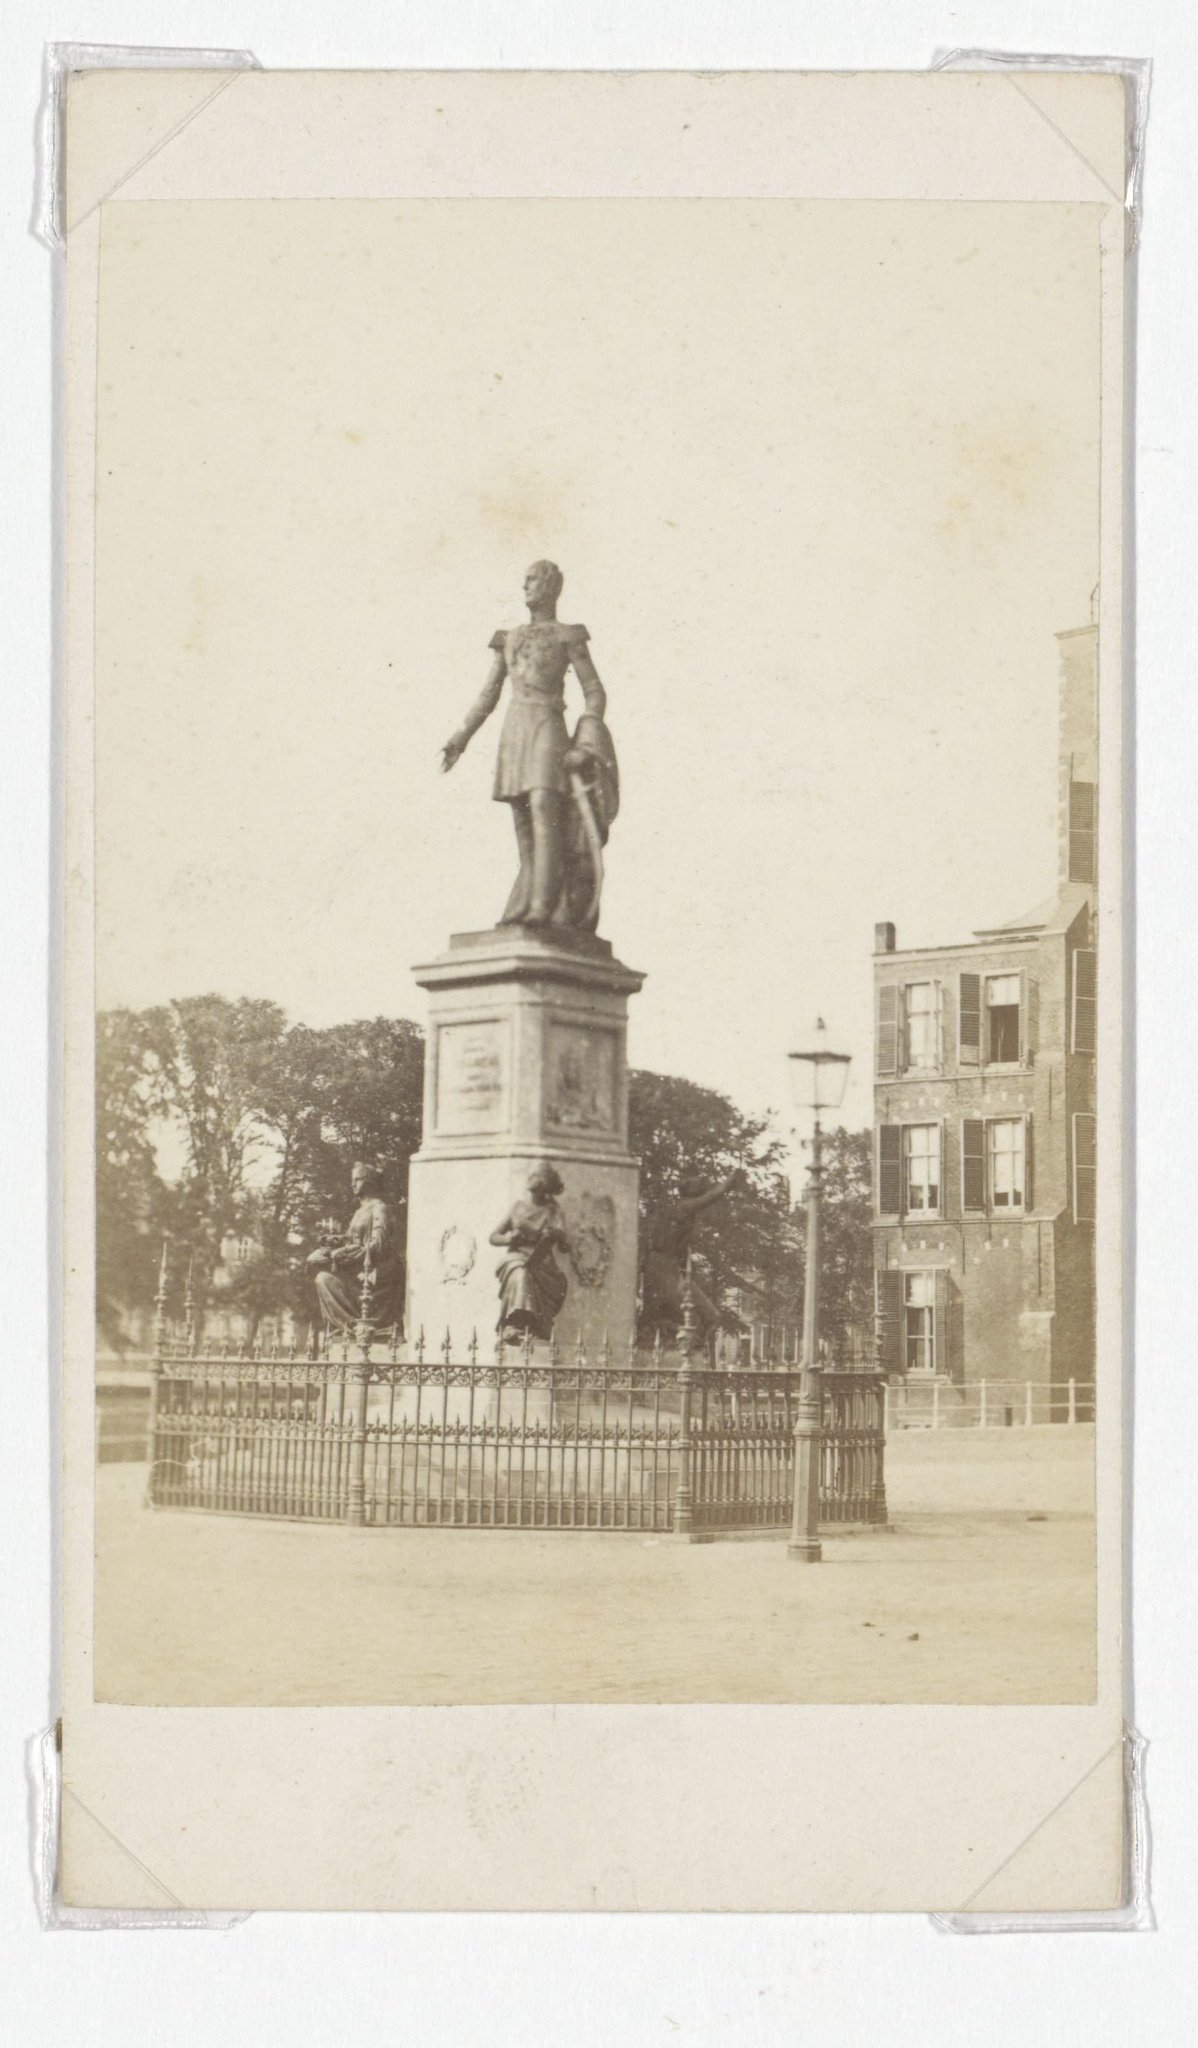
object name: carte de visite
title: Standbeeld van koning Willem II in Den Haag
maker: andries jager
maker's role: publisher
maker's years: 1825-1905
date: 1860-1880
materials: cardboard, paper, photographic support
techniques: albumen print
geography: the hague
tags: william ii of the netherlands, monument, statue, the hague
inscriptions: address: ‘Water 110 Amsterdam’